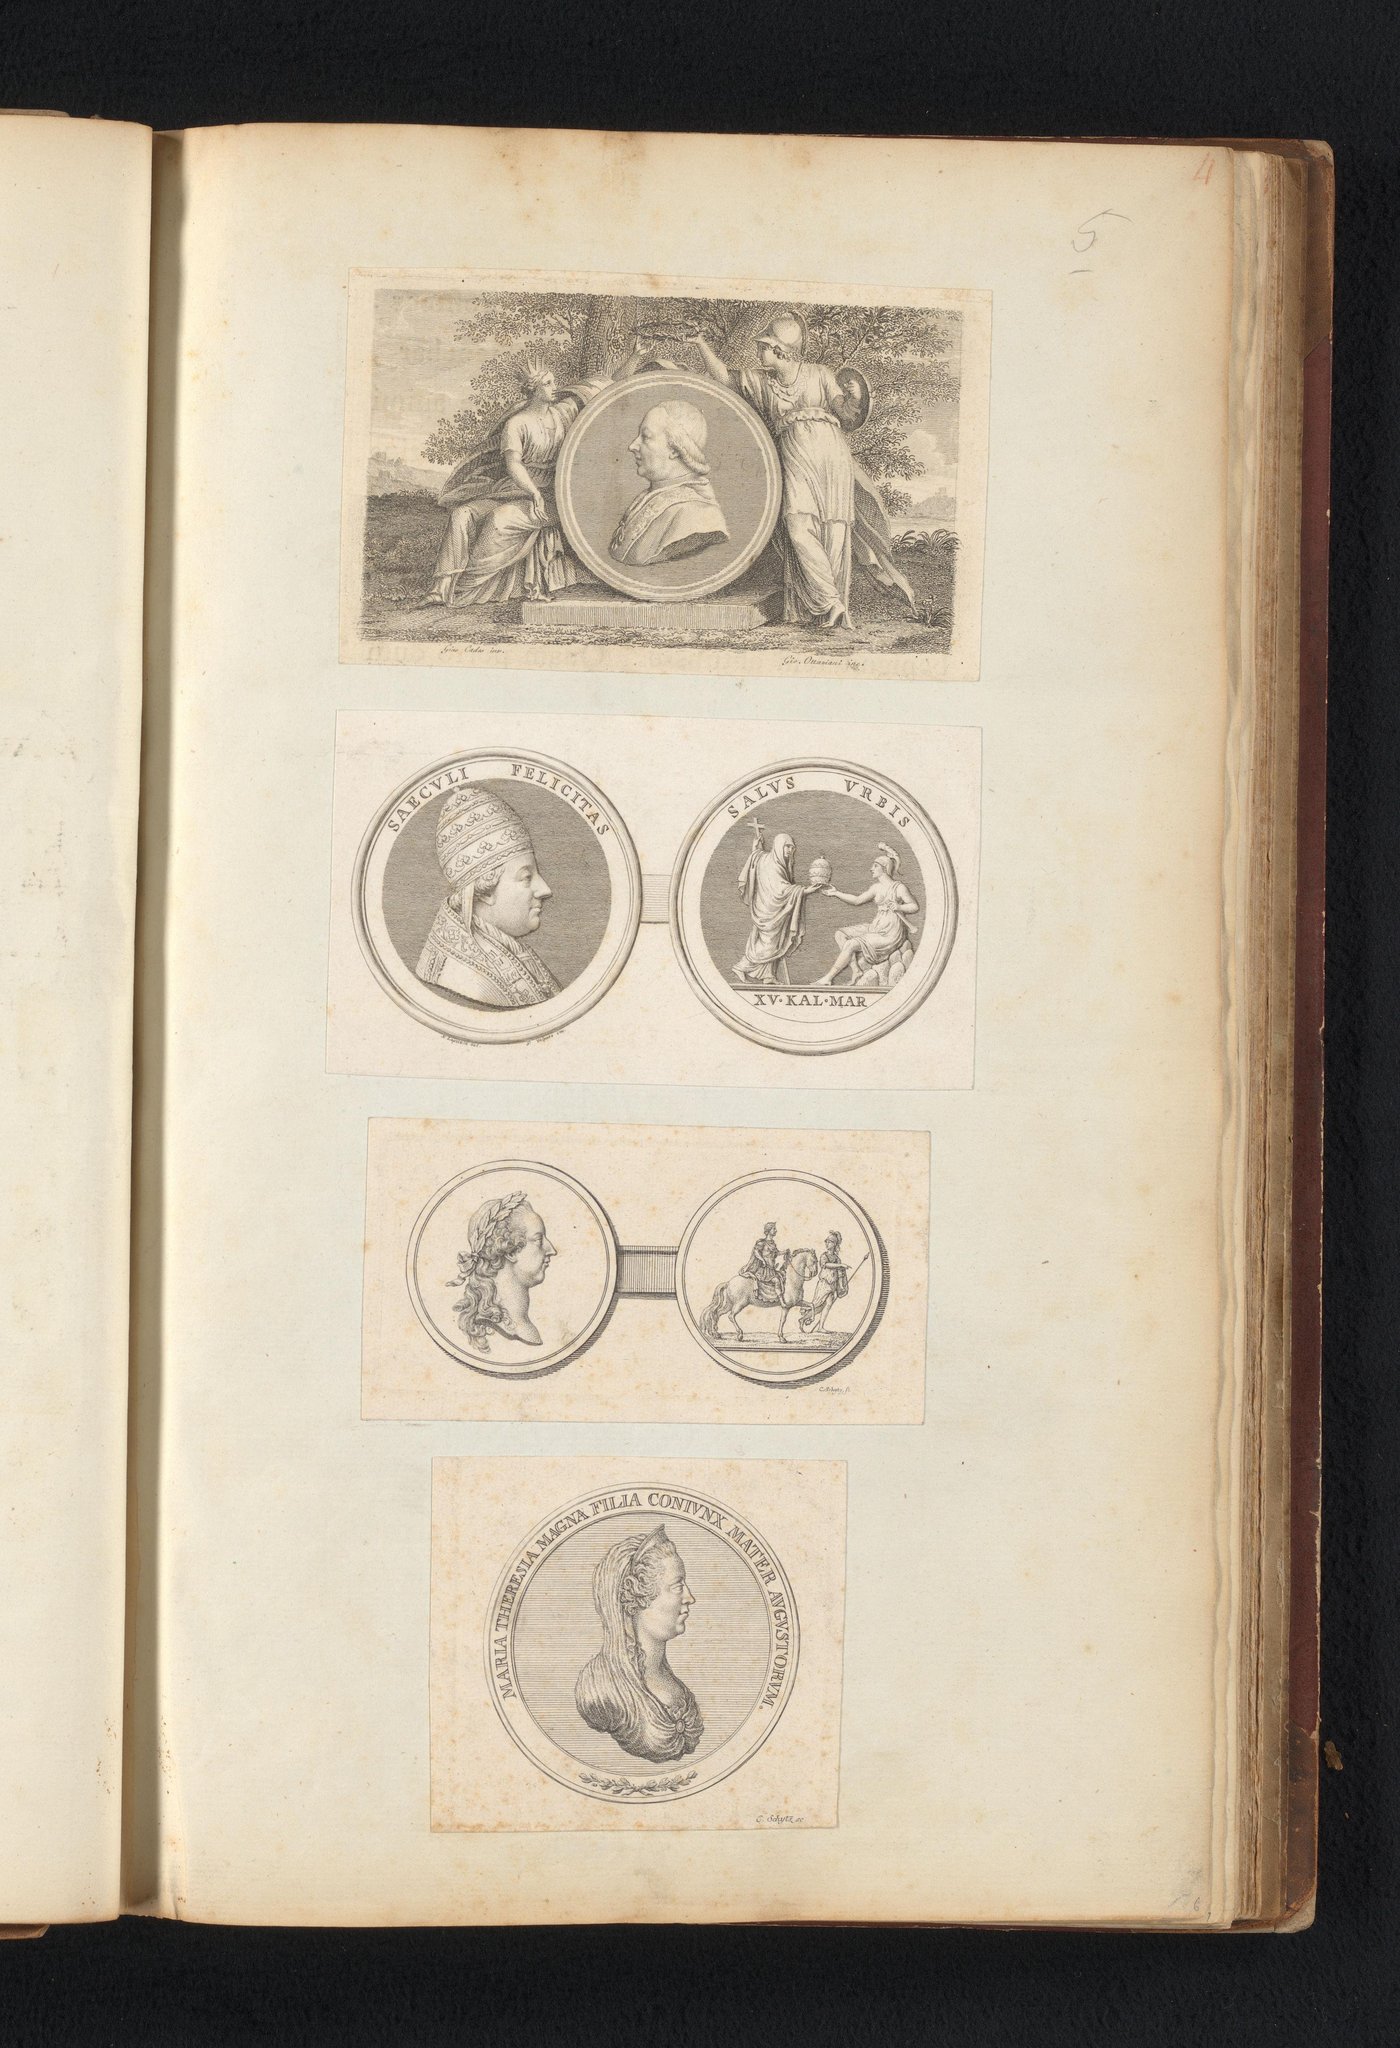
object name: album leaf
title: Portretmedaillons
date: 1750-1816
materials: paper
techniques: engraving, etching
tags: historical persons - bb - woman, historical persons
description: Vier portretmedaillons. Onderdeel van het tweede van twee albums met ingeplakte prenten en tekeningen te dienen als tekenvoorbeelden.